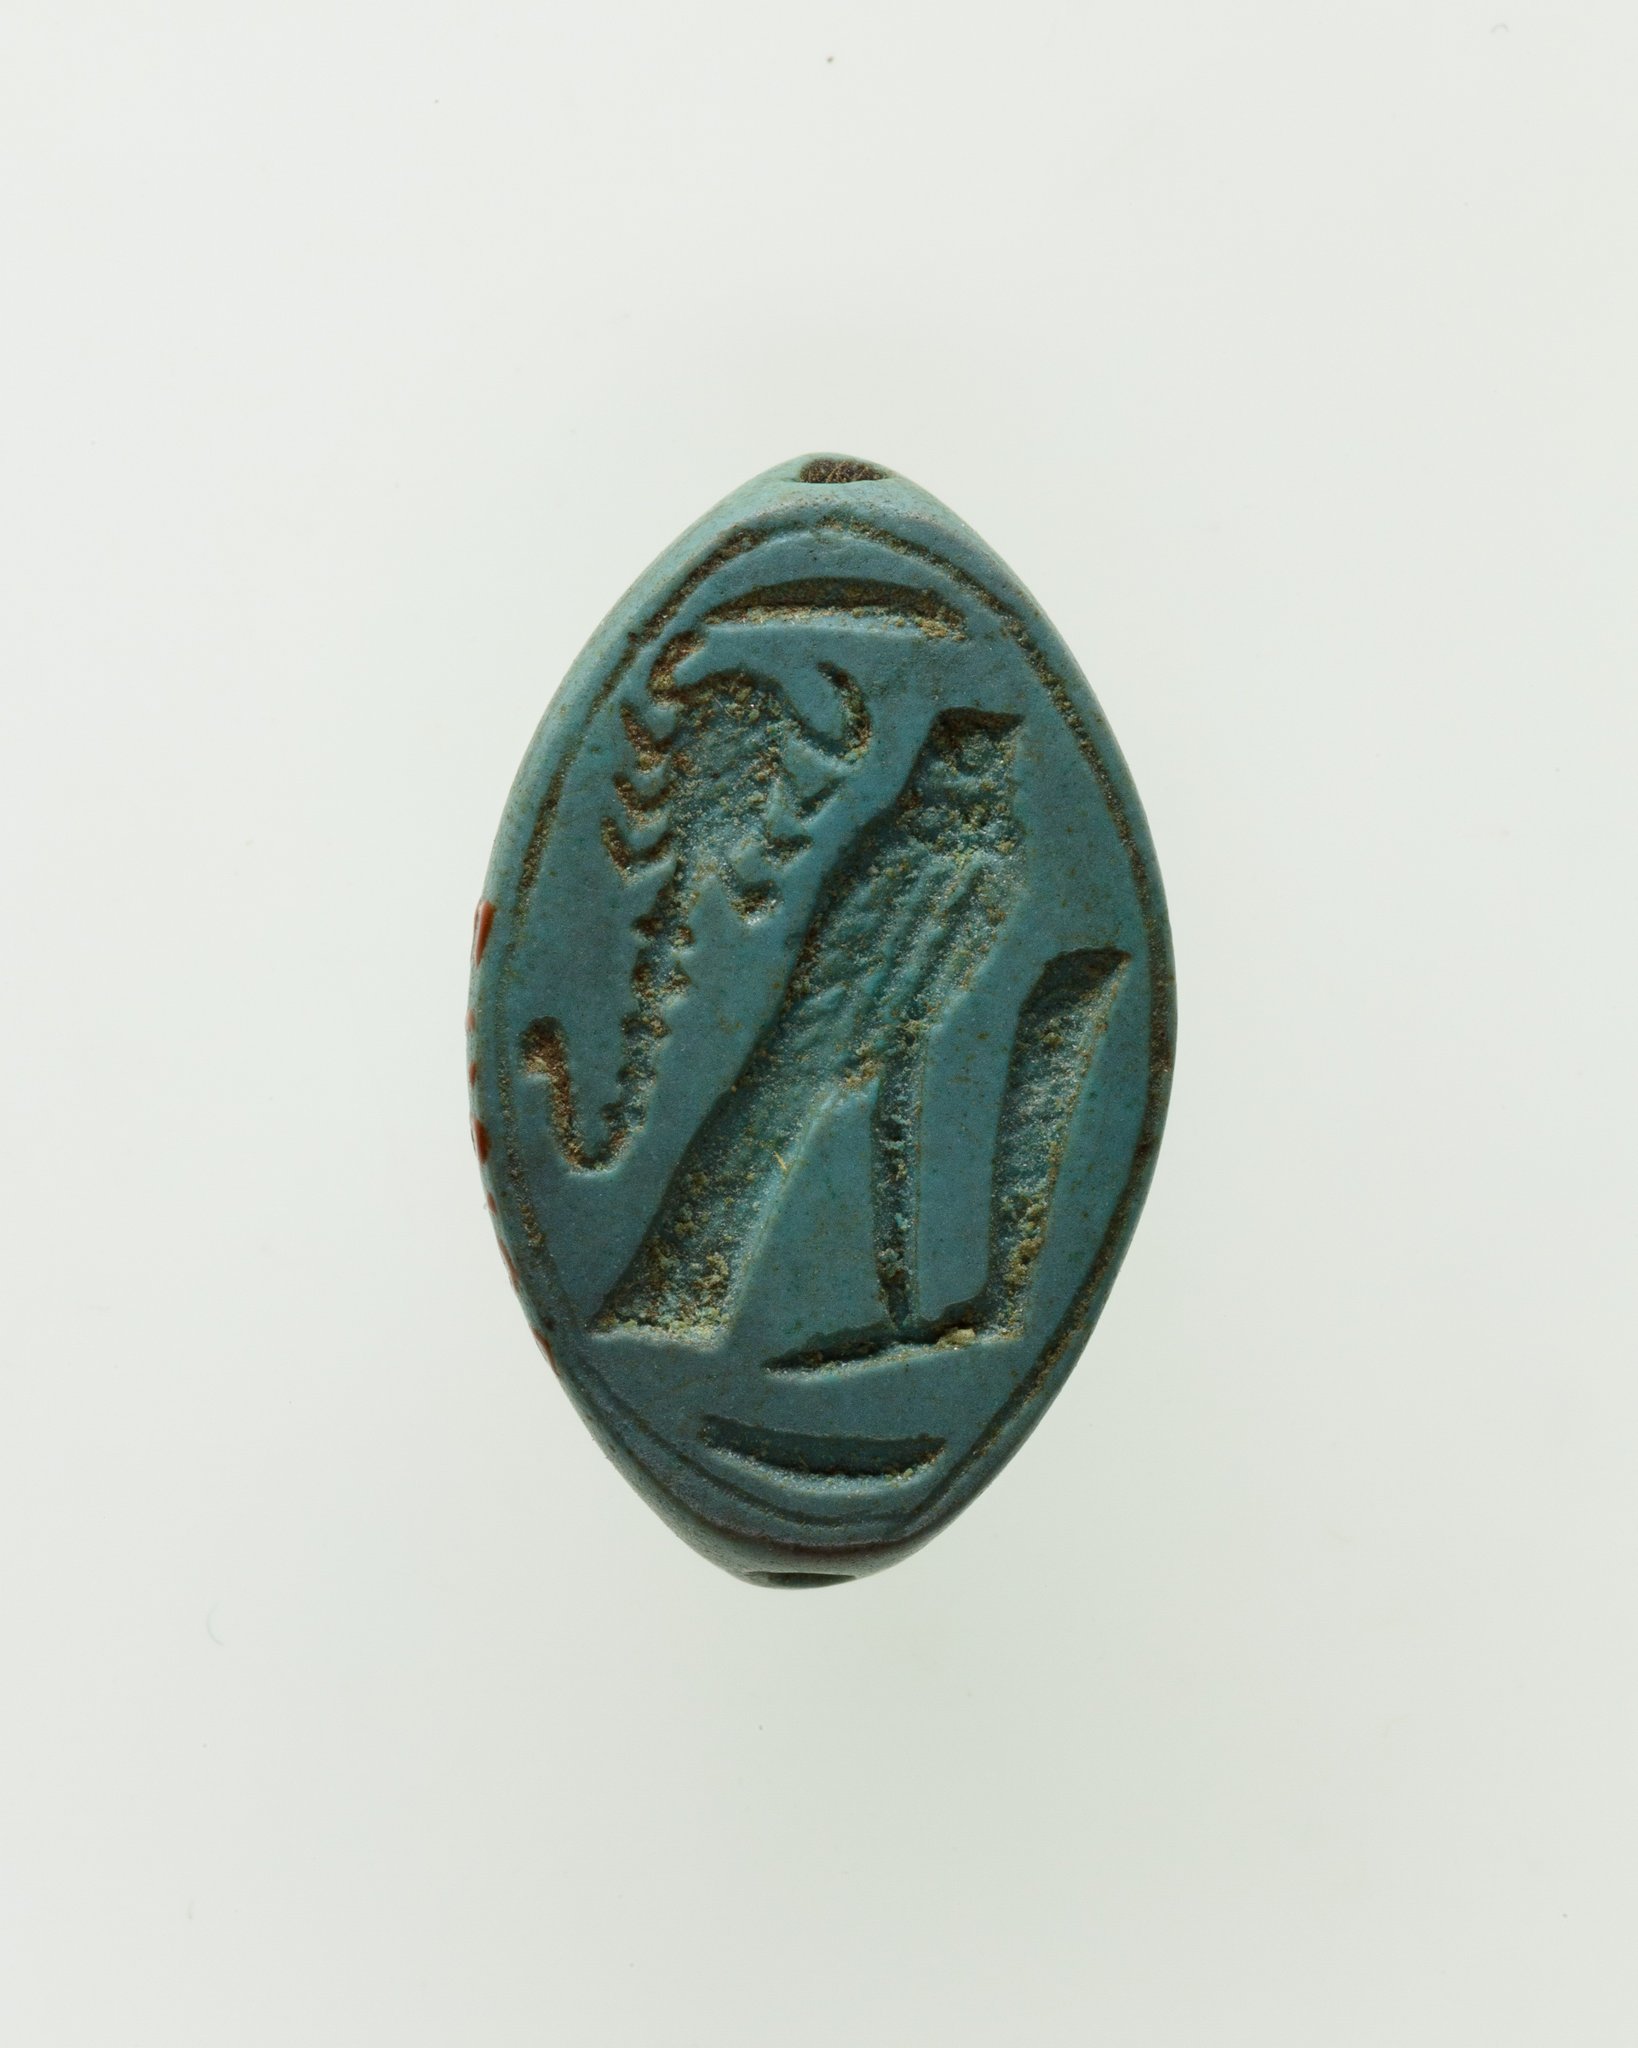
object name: cowroid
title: Cowroid Seal-Amulet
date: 1492-1473 BCE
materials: faience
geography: egypt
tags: falcons,scorpions